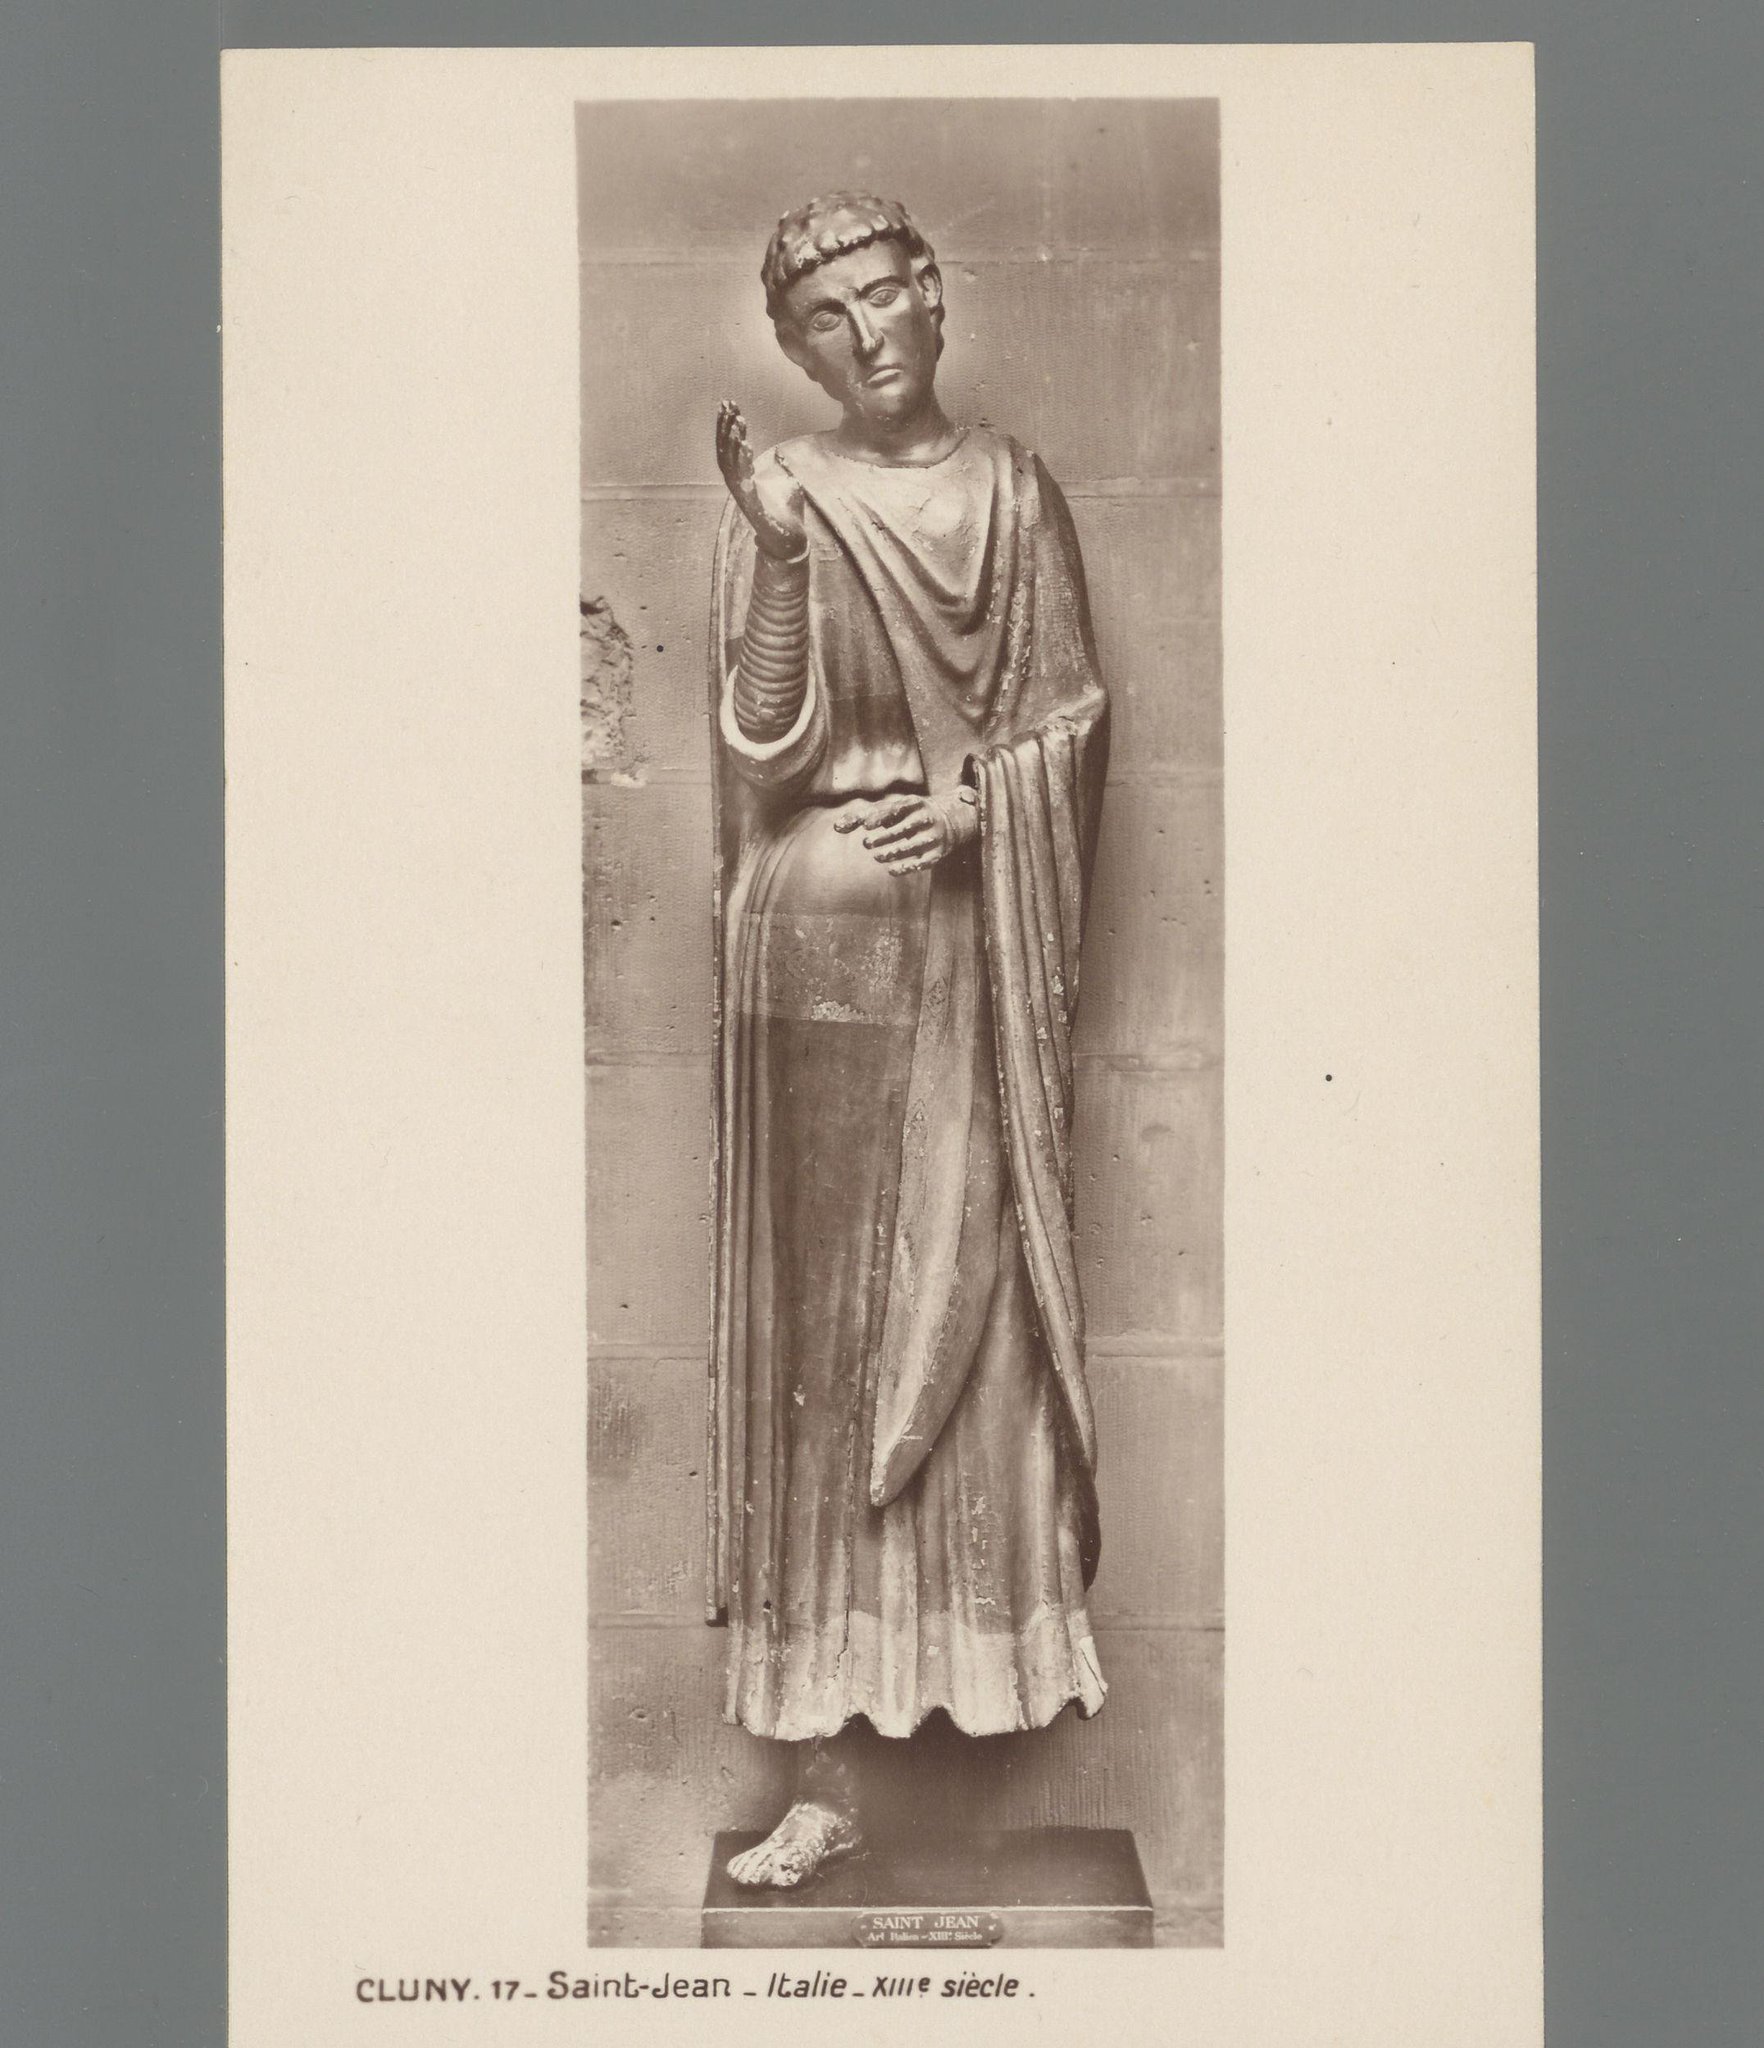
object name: photograph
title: Cluny. Saint-Jean. Italie XIIIe siècle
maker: Anonymous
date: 1903-1930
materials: paper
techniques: gelatin silver print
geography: cluny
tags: statues, paintings, etc. ~ objects of worship in roman religion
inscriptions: collector's mark: ‘AFE v S’